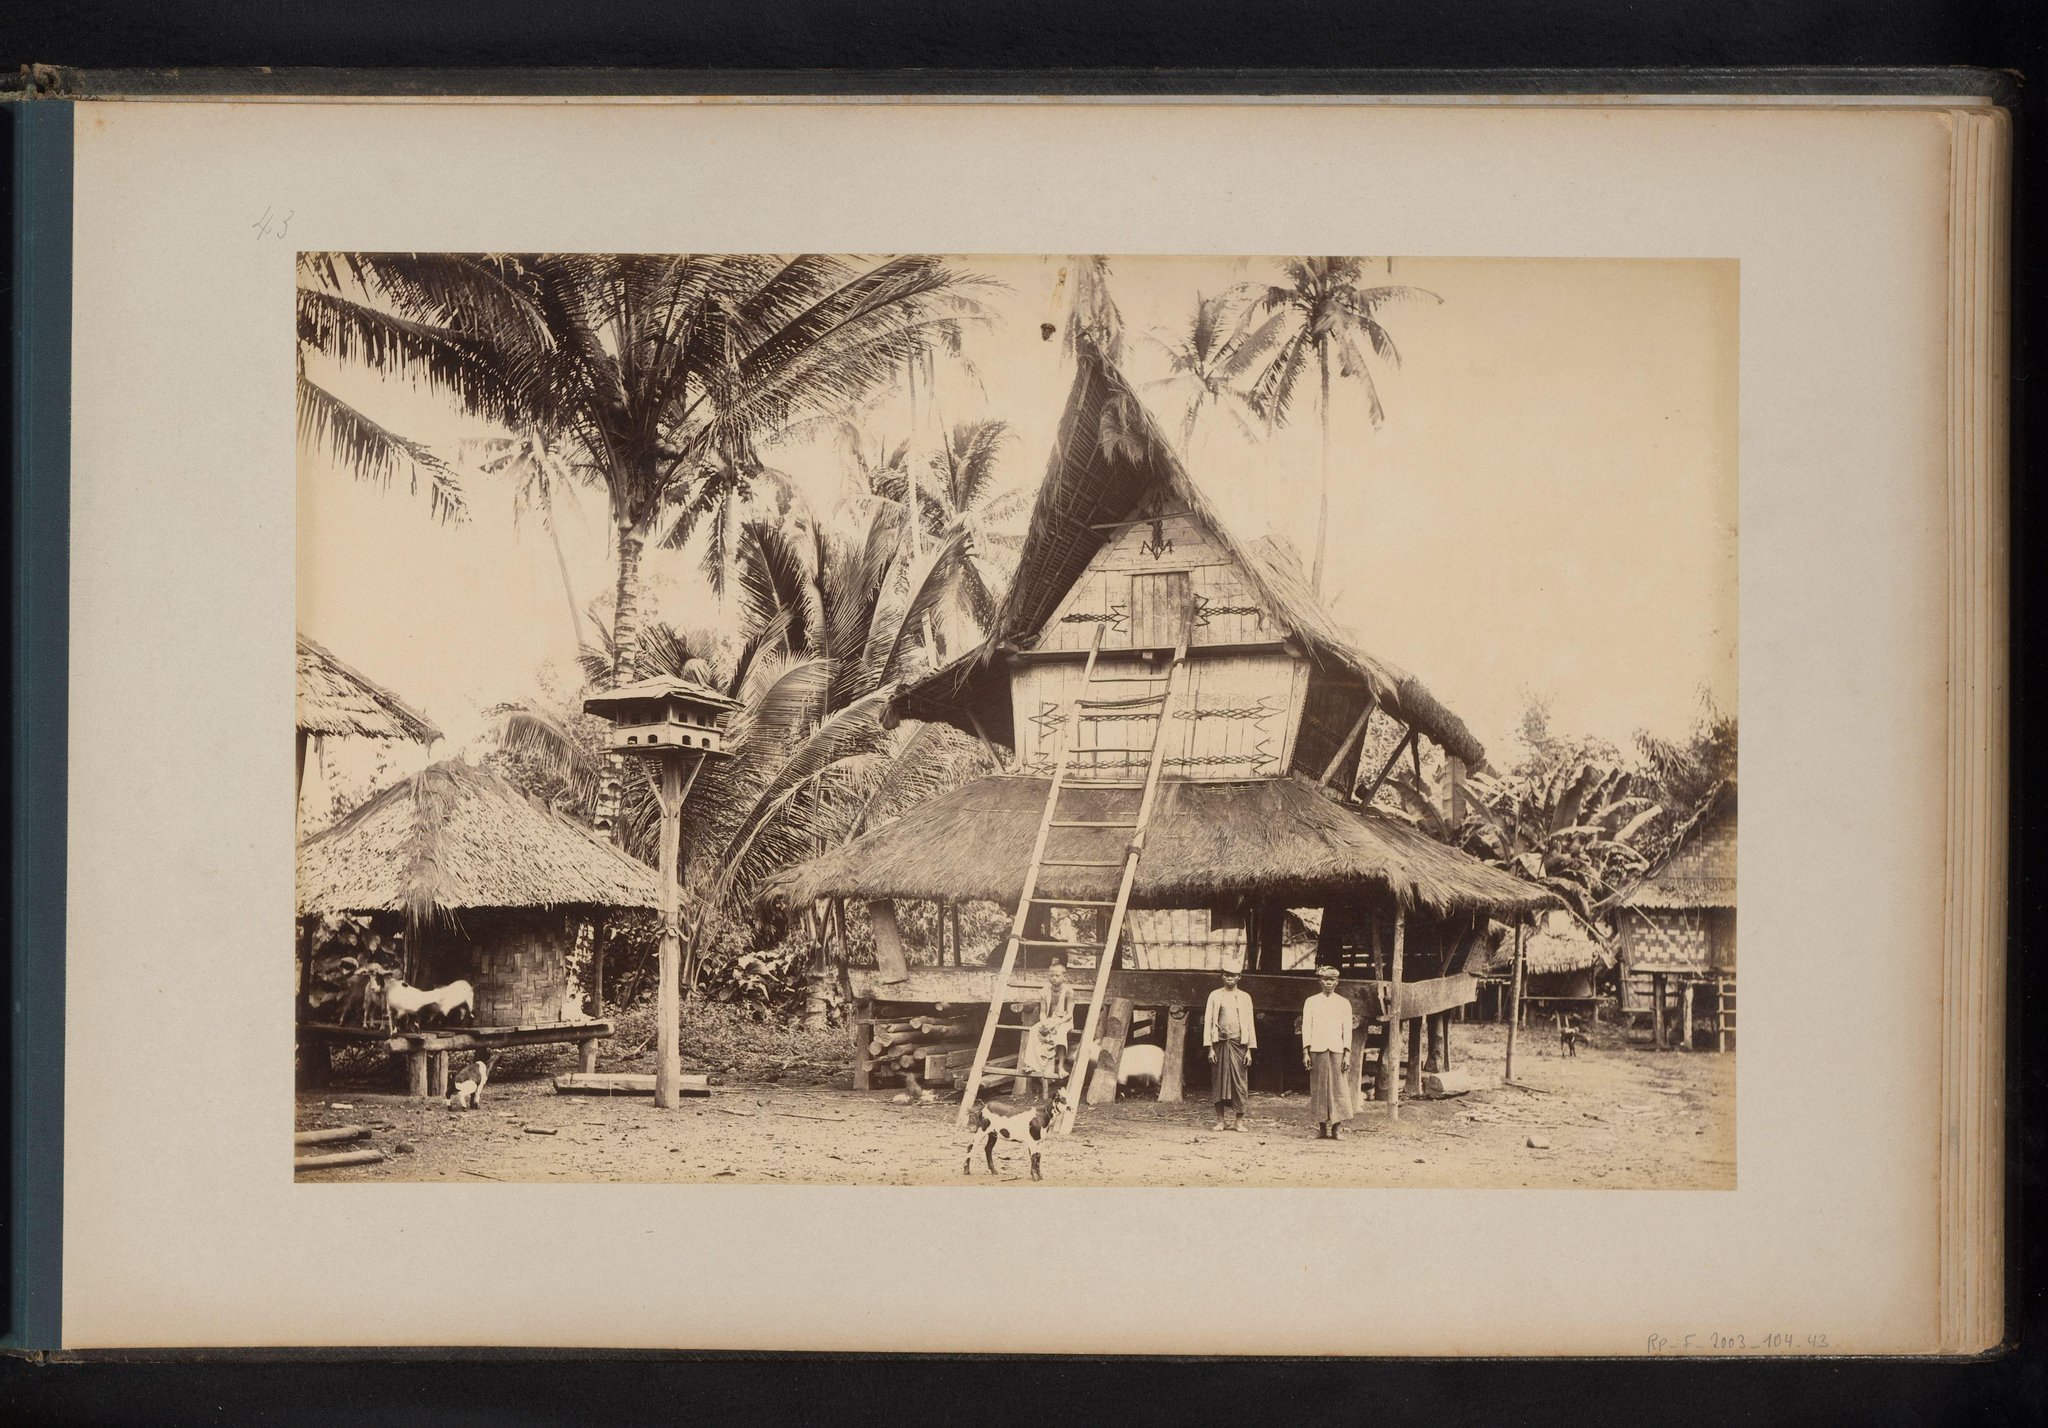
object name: photograph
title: Gezicht op een huis van Bataks in Bandar-Maria, Sumatra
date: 1890-1900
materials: cardboard, photographic support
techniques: albumen print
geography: sumatra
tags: rural housing, e.g. country-house, villa, cottage, sumatra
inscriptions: number: ‘43’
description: In de lijst van afbeeldingen wordt deze foto beschreven met de woorden "Battackhaus in Bandar-Maria".